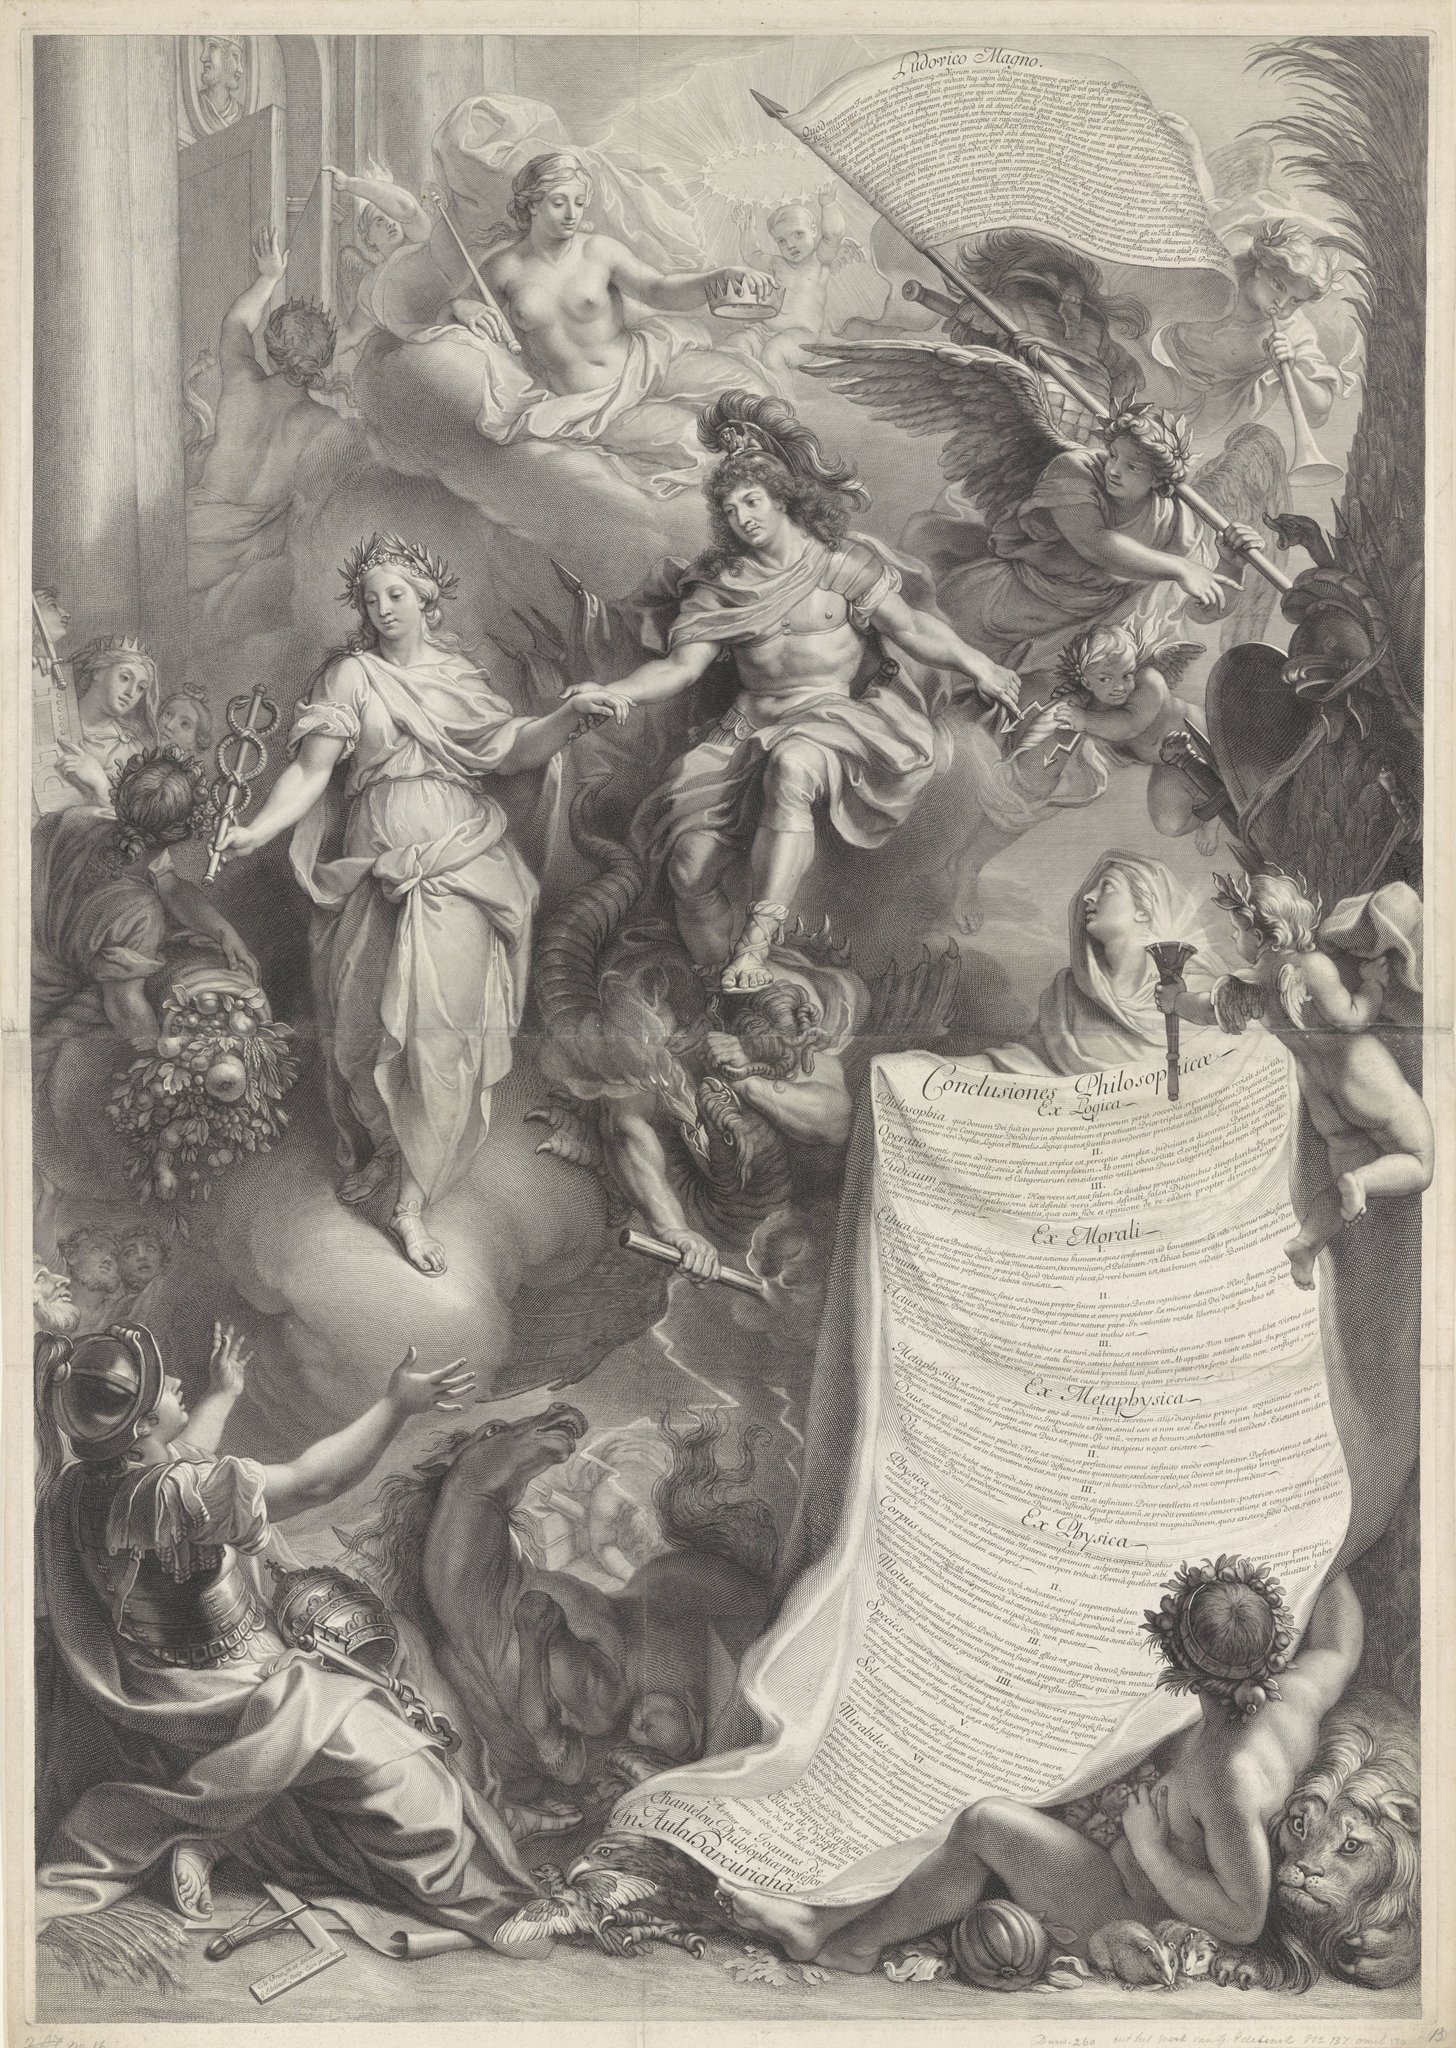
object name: print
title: Allegorie op de macht van Lodewijk XIV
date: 1680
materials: paper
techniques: engraving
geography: paris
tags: lodewijk xiv (koning van frankrijk)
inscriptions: collector's mark: Lugt 240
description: Prent uit twee delen. Koning Lodewijk XIV, in Romeins tenue, vertrapt een monster terwijl de personificatie van Onsterfelijkheid hem kroont en Vrede hem aan de hand neemt. Een engel met een vlag wijst op wapenuitrusting, vastgebonden aan een palmboom. De tekst op het uitgerolde doek geeft de hoofdpunten uit een filosofisch tractaat van J.B. Colbert de Croissy.